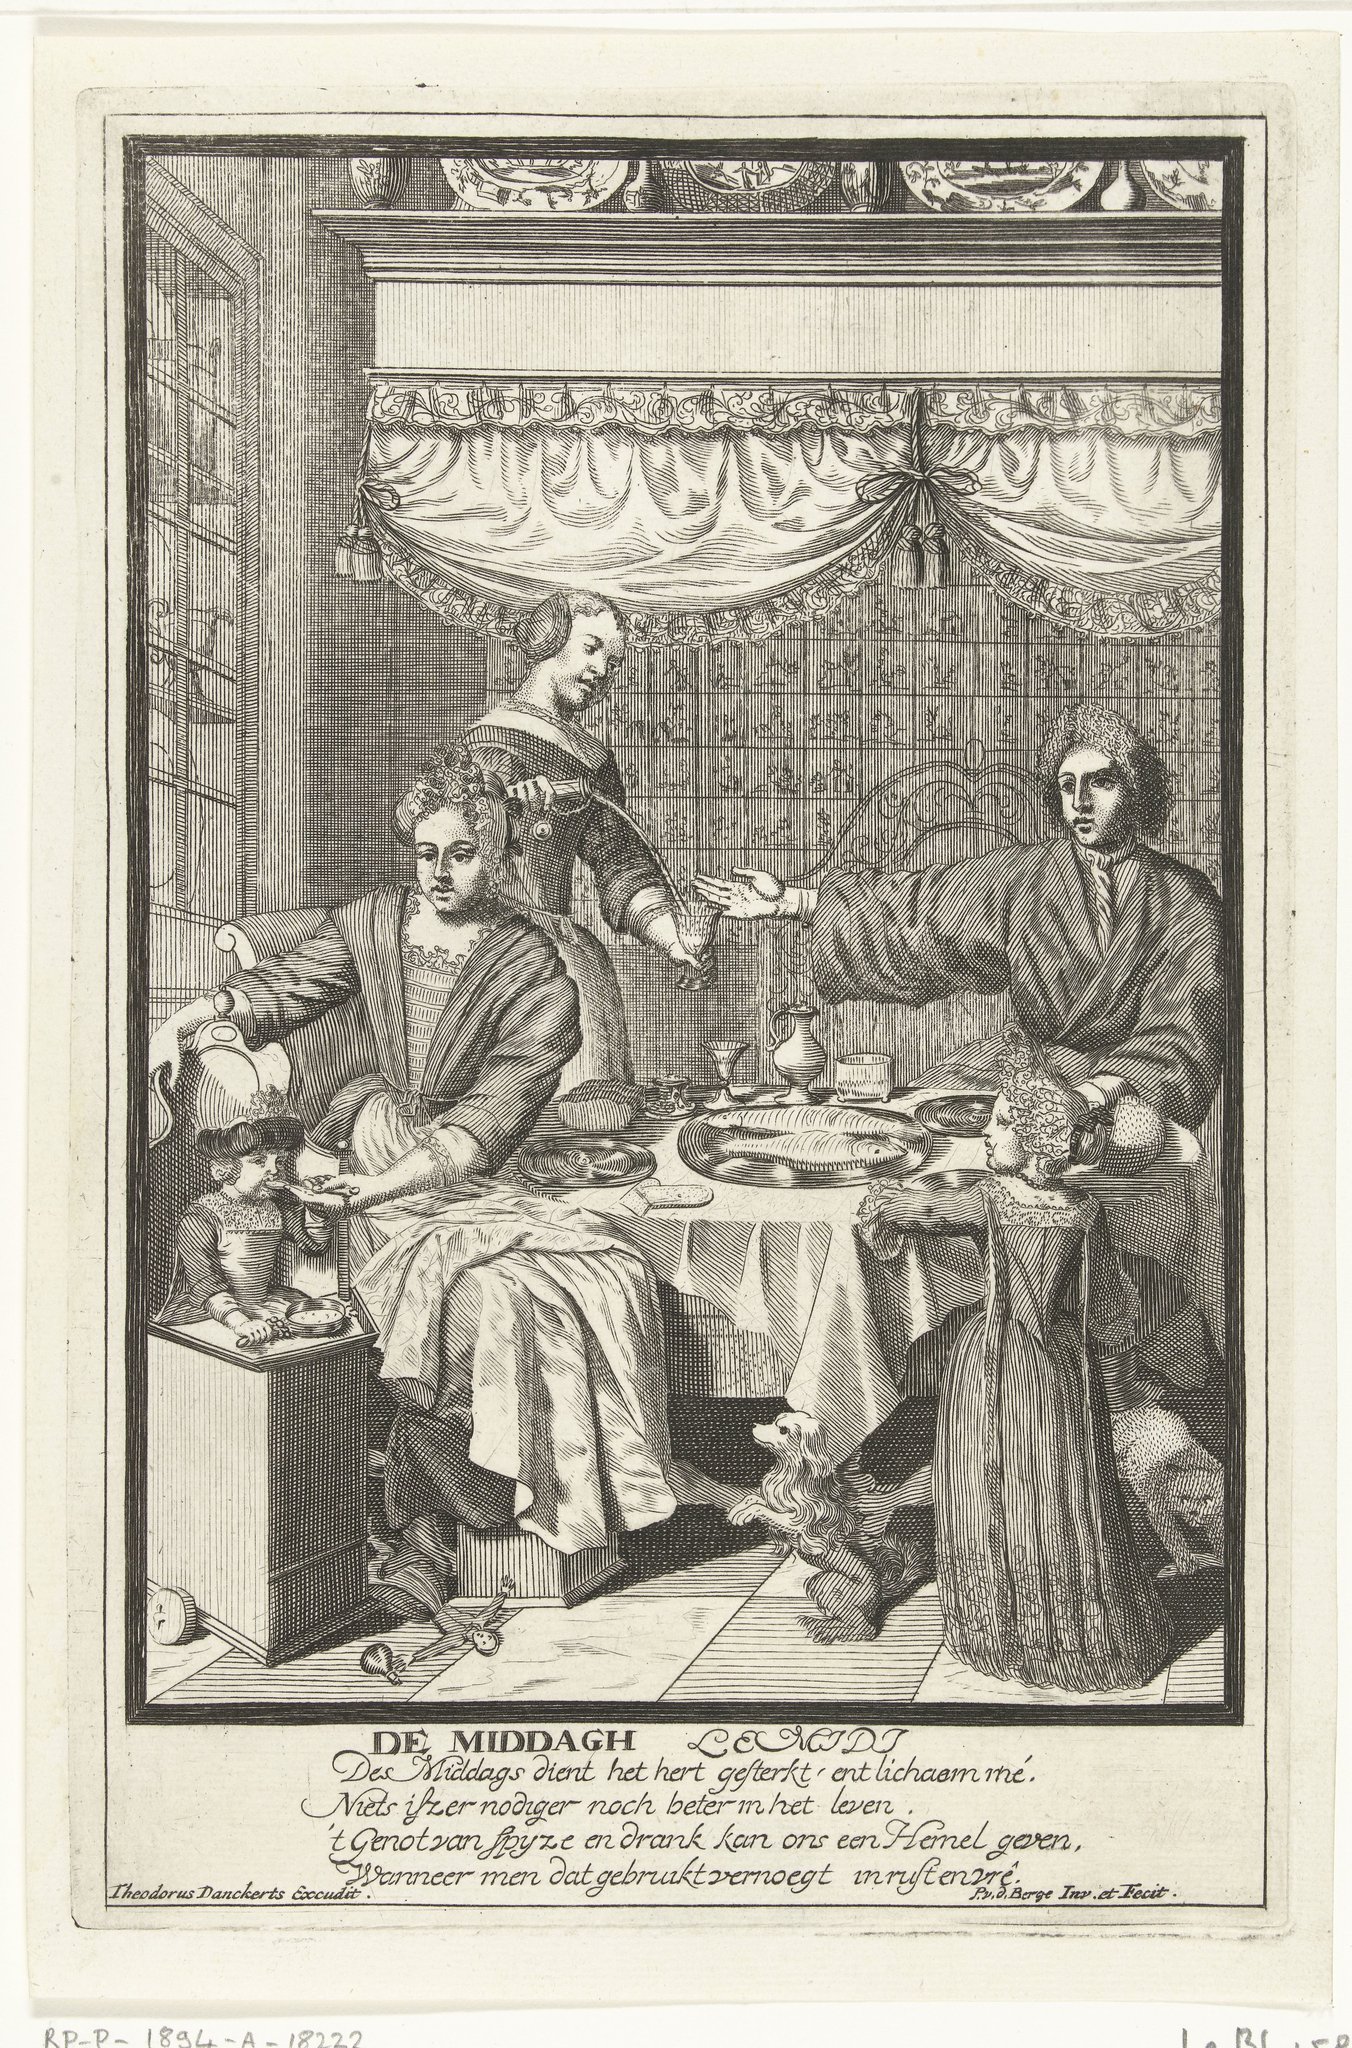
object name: print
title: De vier tijden van de dag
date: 1702-1726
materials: paper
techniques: engraving, etching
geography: amsterdam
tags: baby-chair, feeding a baby, midday meal, lunch, afternoon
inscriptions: collector's mark: Lugt 2228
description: In een Hollands interieur zit een gezin aan een gedekte tafel waarop een schaal met vissen, brood, borden en glazen. Een dienstmeid schenkt een glas in. De ouders zitten, een kind staat aan tafel. Een peuter zit in een kinderstoel en wordt gevoerd. Een hondje zit op. Met een onderschrift van vier regels in het Nederlands. Tweede prent uit de serie: de vier tijden van de dag.